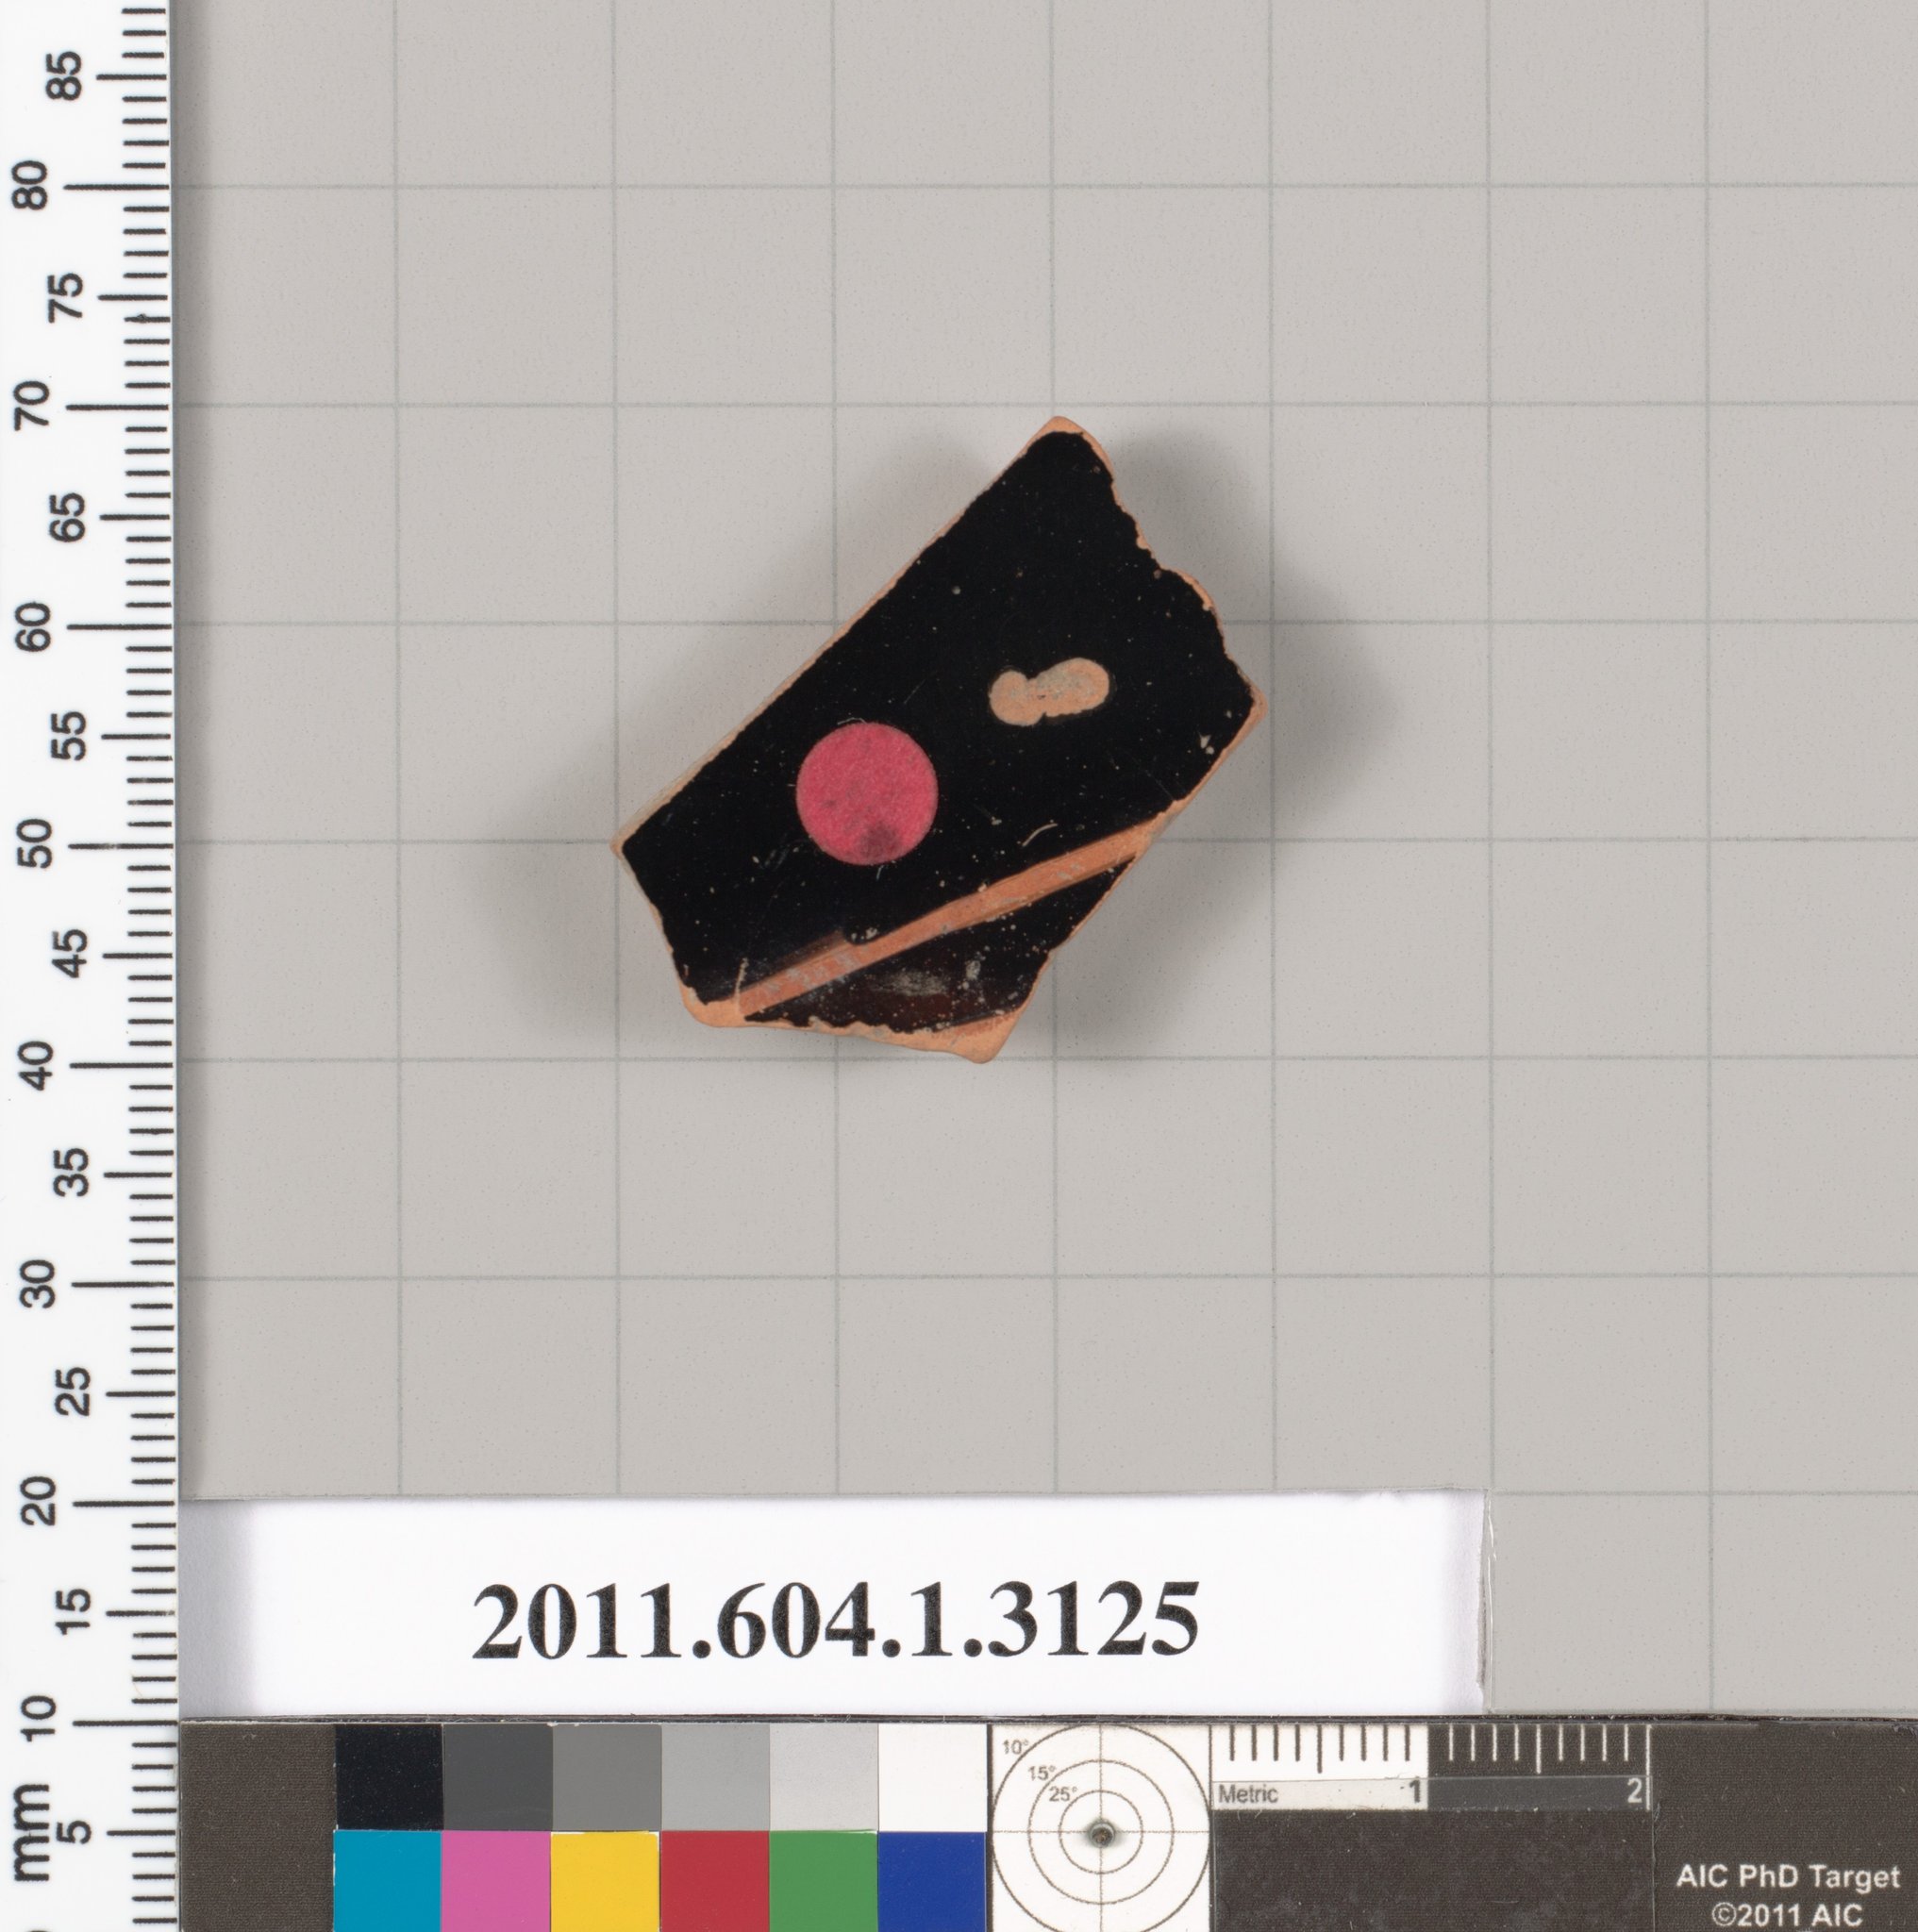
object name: kylix fragment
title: Terracotta fragment of a kylix (drinking cup)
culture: greek, attic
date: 500-451 BCE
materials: terracotta